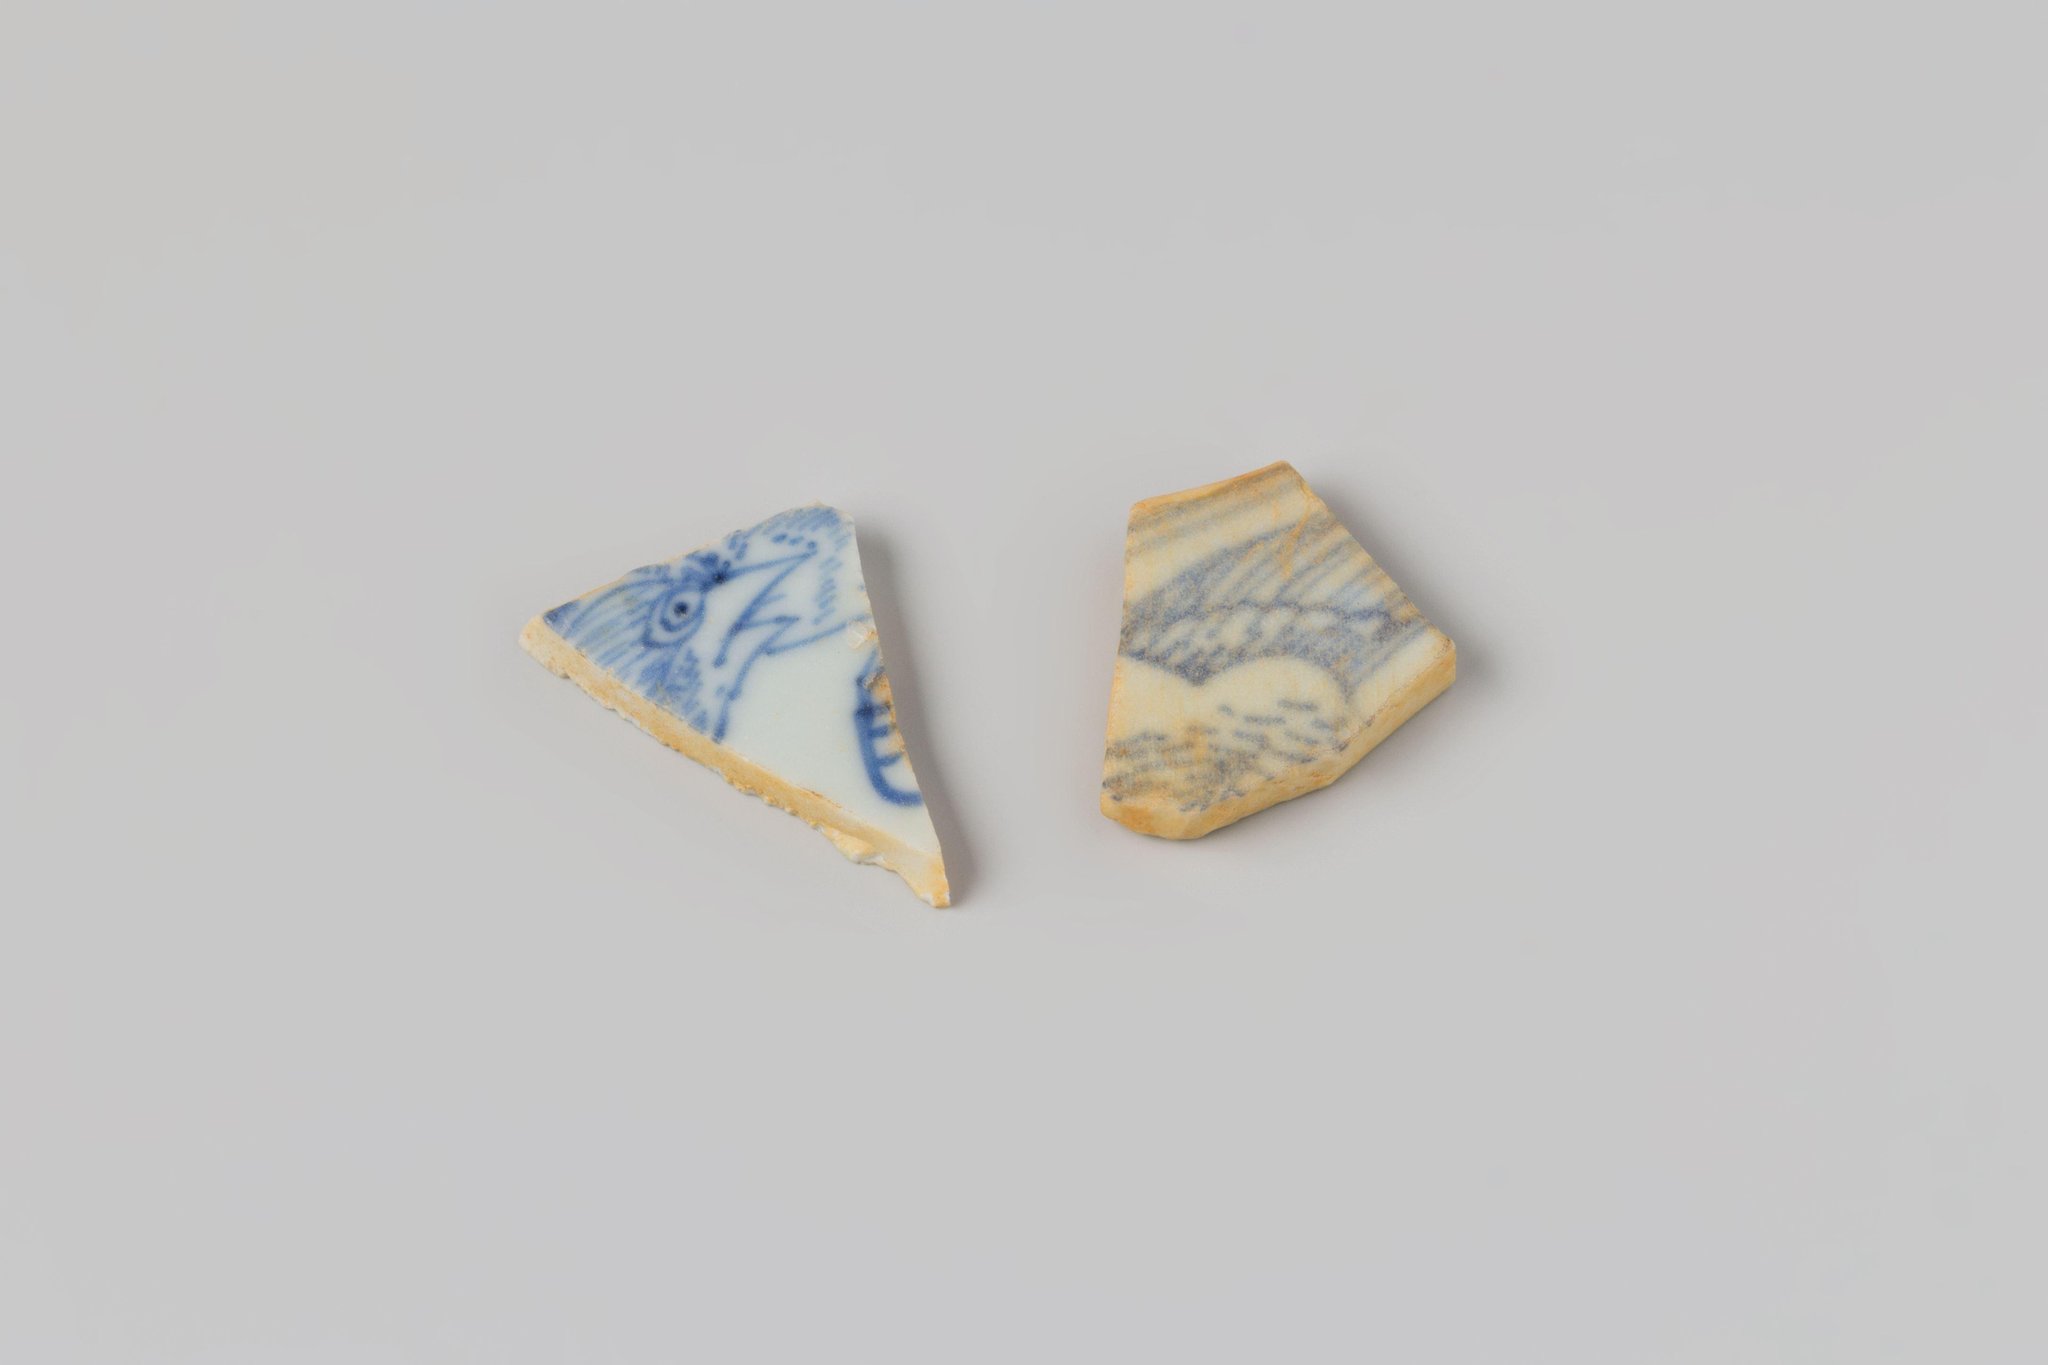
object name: plate dish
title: Scherven van borden uit het wrak van de Oost-Indiëvaarder Hollandia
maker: Anonymous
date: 1700-1743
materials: porcelain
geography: netherlands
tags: verenigde oostindische compagnie, hollandia (schip), annet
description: Porcelain, plate, type 1; fragm of rim, sim NG 1980-27H1662.